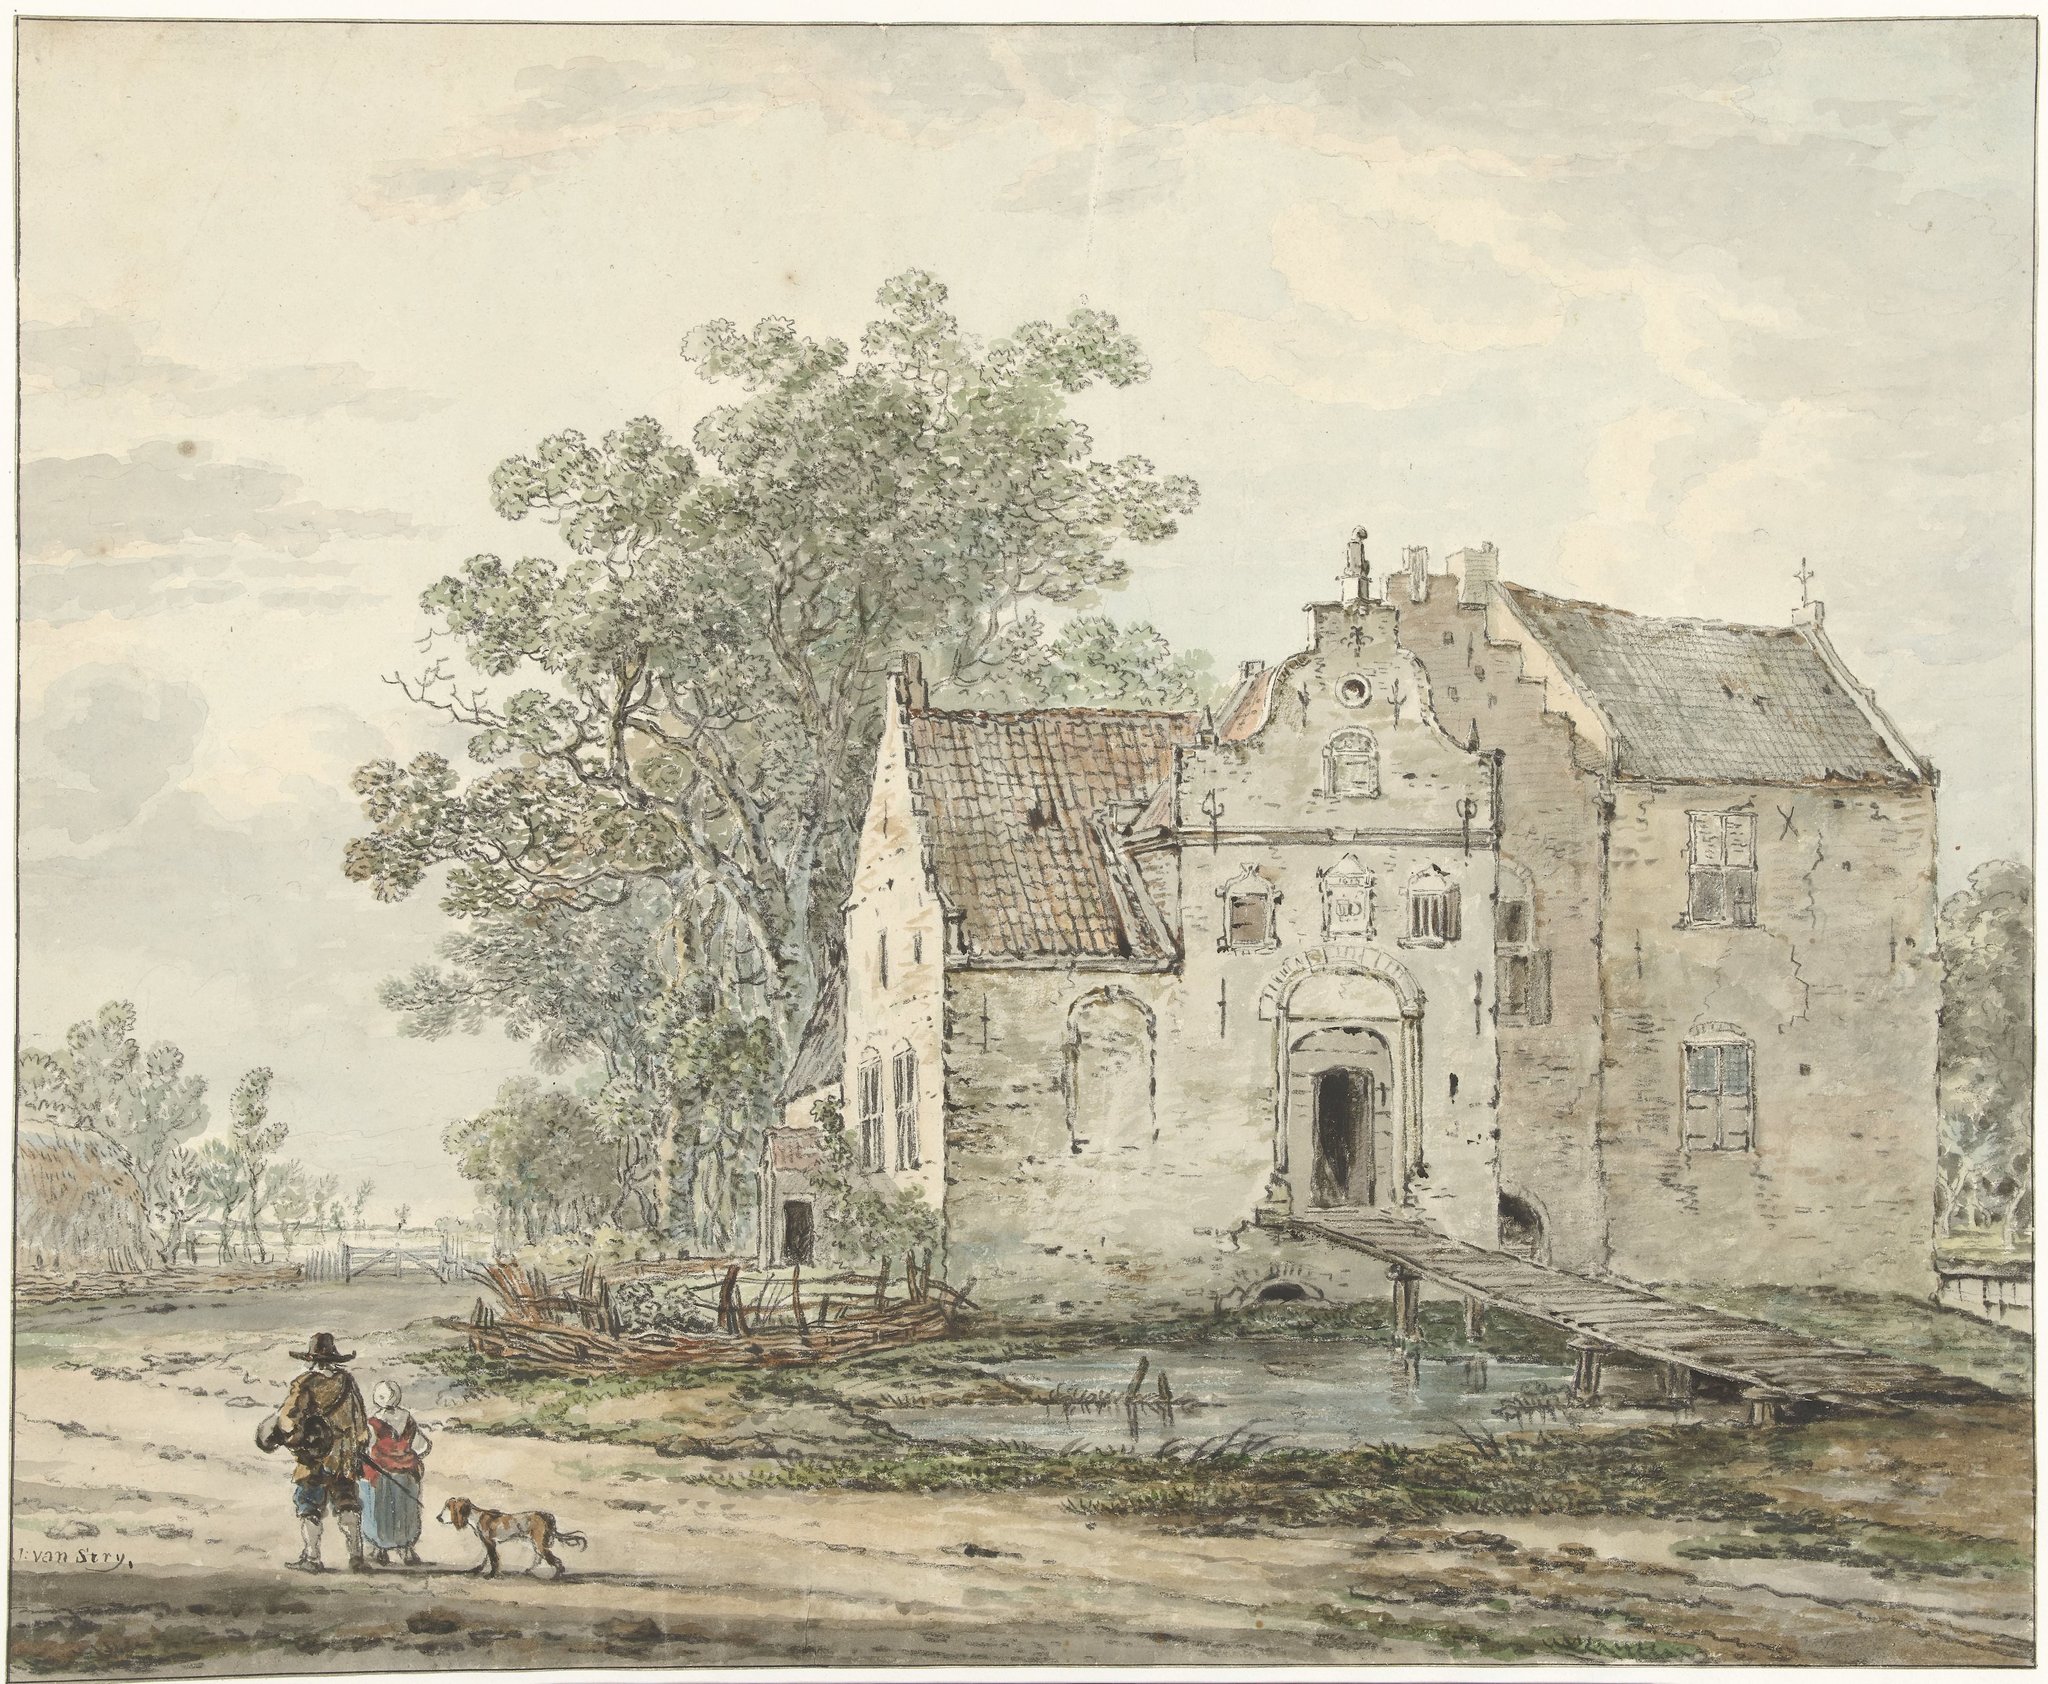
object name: watercolor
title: Kasteel IJzendoorn in de Betuwe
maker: jacob van strij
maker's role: draughtsman, painter, print maker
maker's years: 1756-1815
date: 1766-1815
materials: chalk, paper, watercolor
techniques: brush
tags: castle